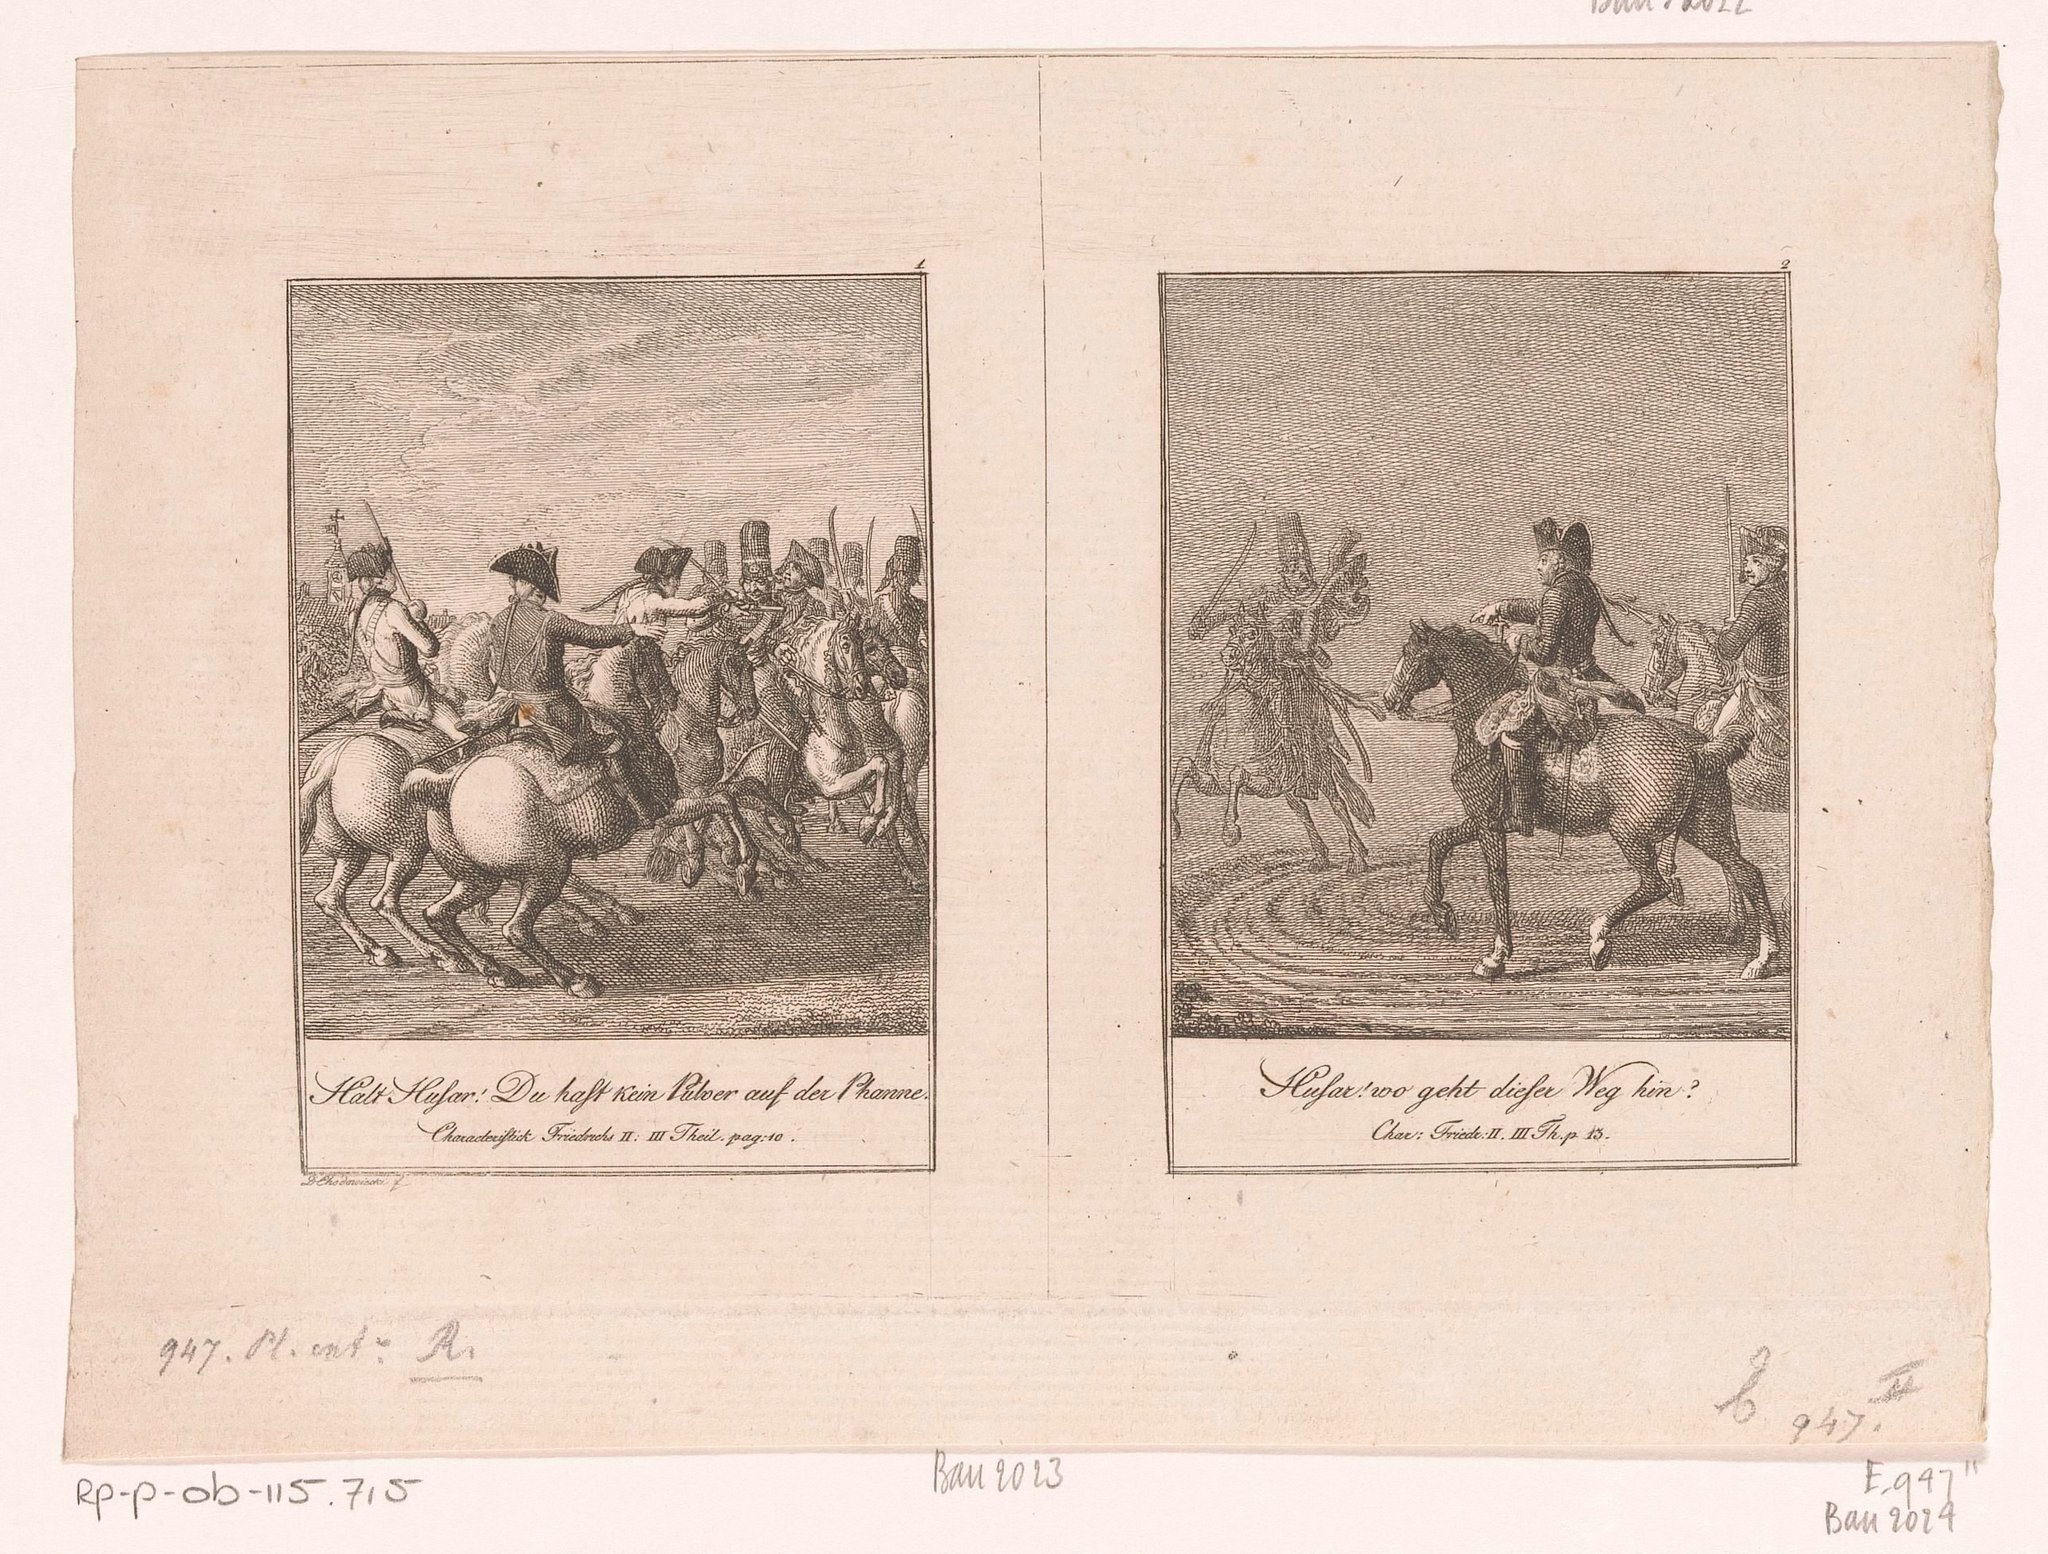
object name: print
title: Twee voorstellingen uit de anekdoten van Friedrich II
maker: daniel nikolaus chodowiecki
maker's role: draughtsman, print maker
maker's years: 1726-1801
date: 1800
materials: paper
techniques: etching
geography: berlin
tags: berlin, frederick ii (king of prussia), riding a horse, ass, or mule; rider, horseman, battle, asking the way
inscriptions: collector's mark: Lugt 2228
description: Prenten gebruikt voor: Militärischer Kalender auf das Jahr 1801 (...). Berlijn: Johann Friedrich Unger, [1800].